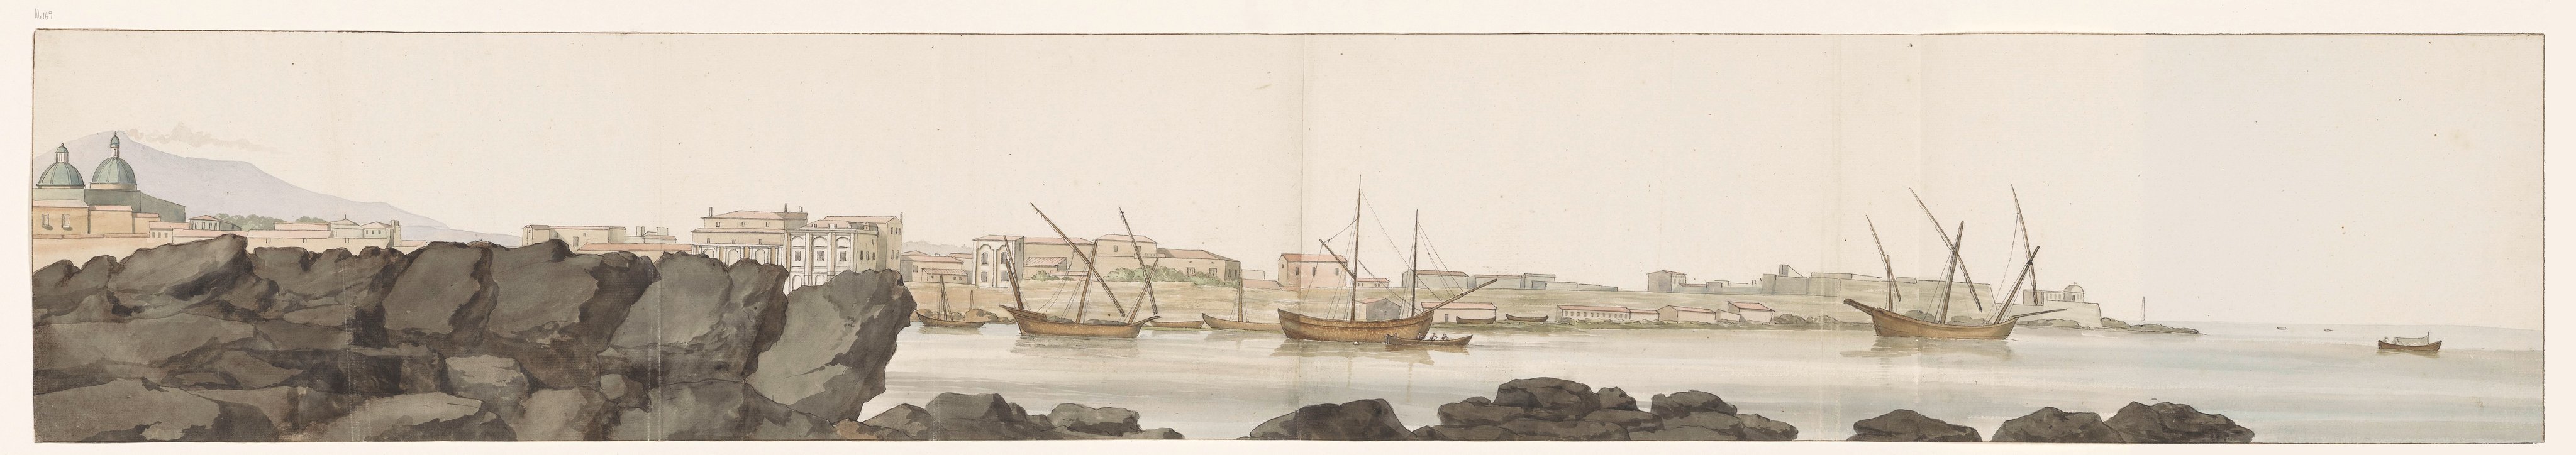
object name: watercolor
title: Vue du Port de Catane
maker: louis ducros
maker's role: draughtsman, print maker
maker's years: 1748-1810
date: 1778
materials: chalk, paper, watercolor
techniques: brush, pen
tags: harbour, prospect of city, town panorama, silhouette of city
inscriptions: inscription: ‘No 169 Vue du Port de Catane’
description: Tekening uit het album 'Voyage en Italie, en Sicile et à Malte', 1778.